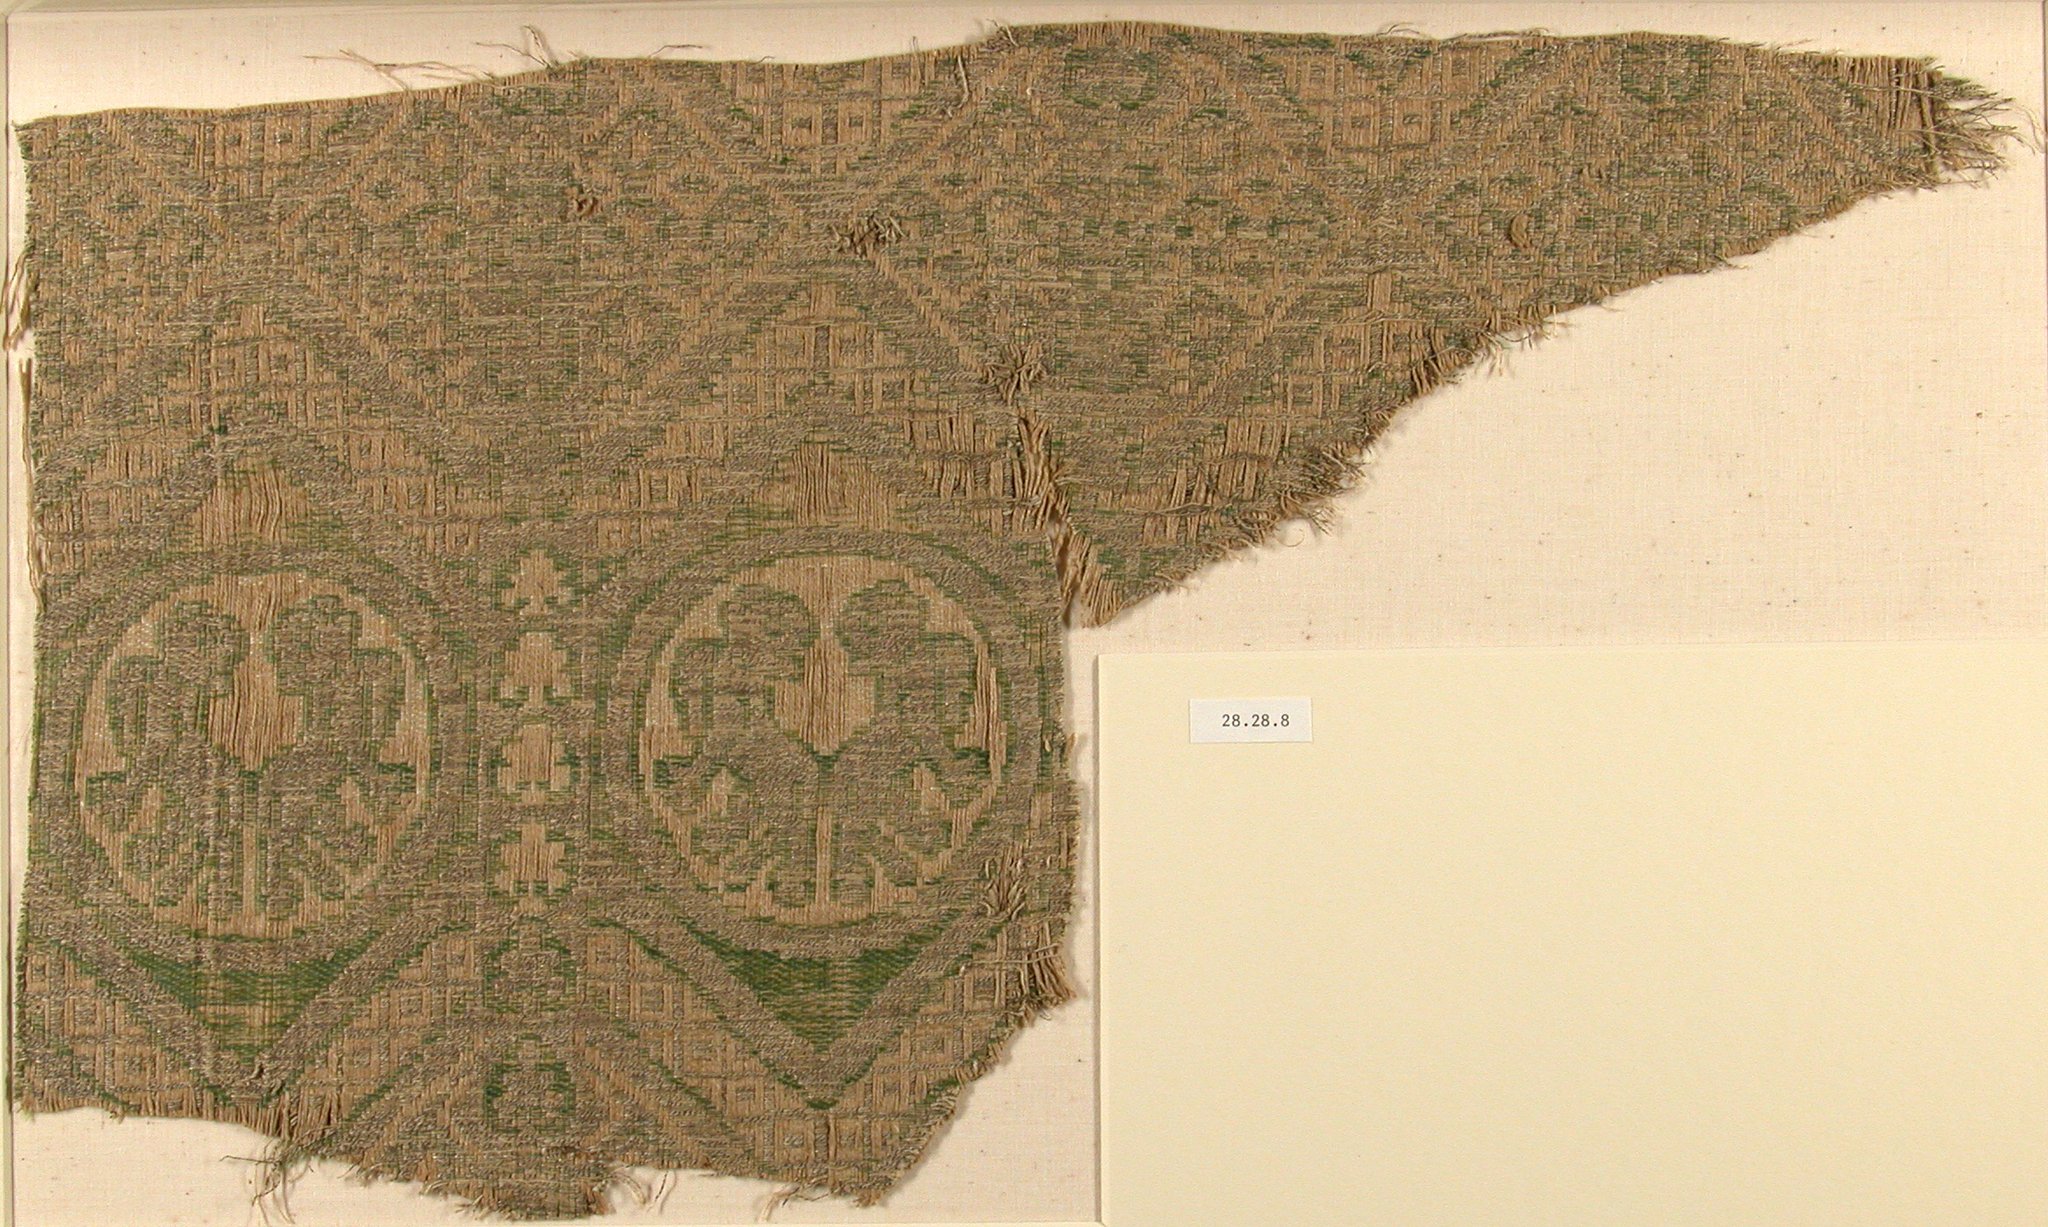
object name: textile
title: Textile with Beast and Geometric Designs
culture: german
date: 1101-1300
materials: gilt, hemp, silk, tin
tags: animals